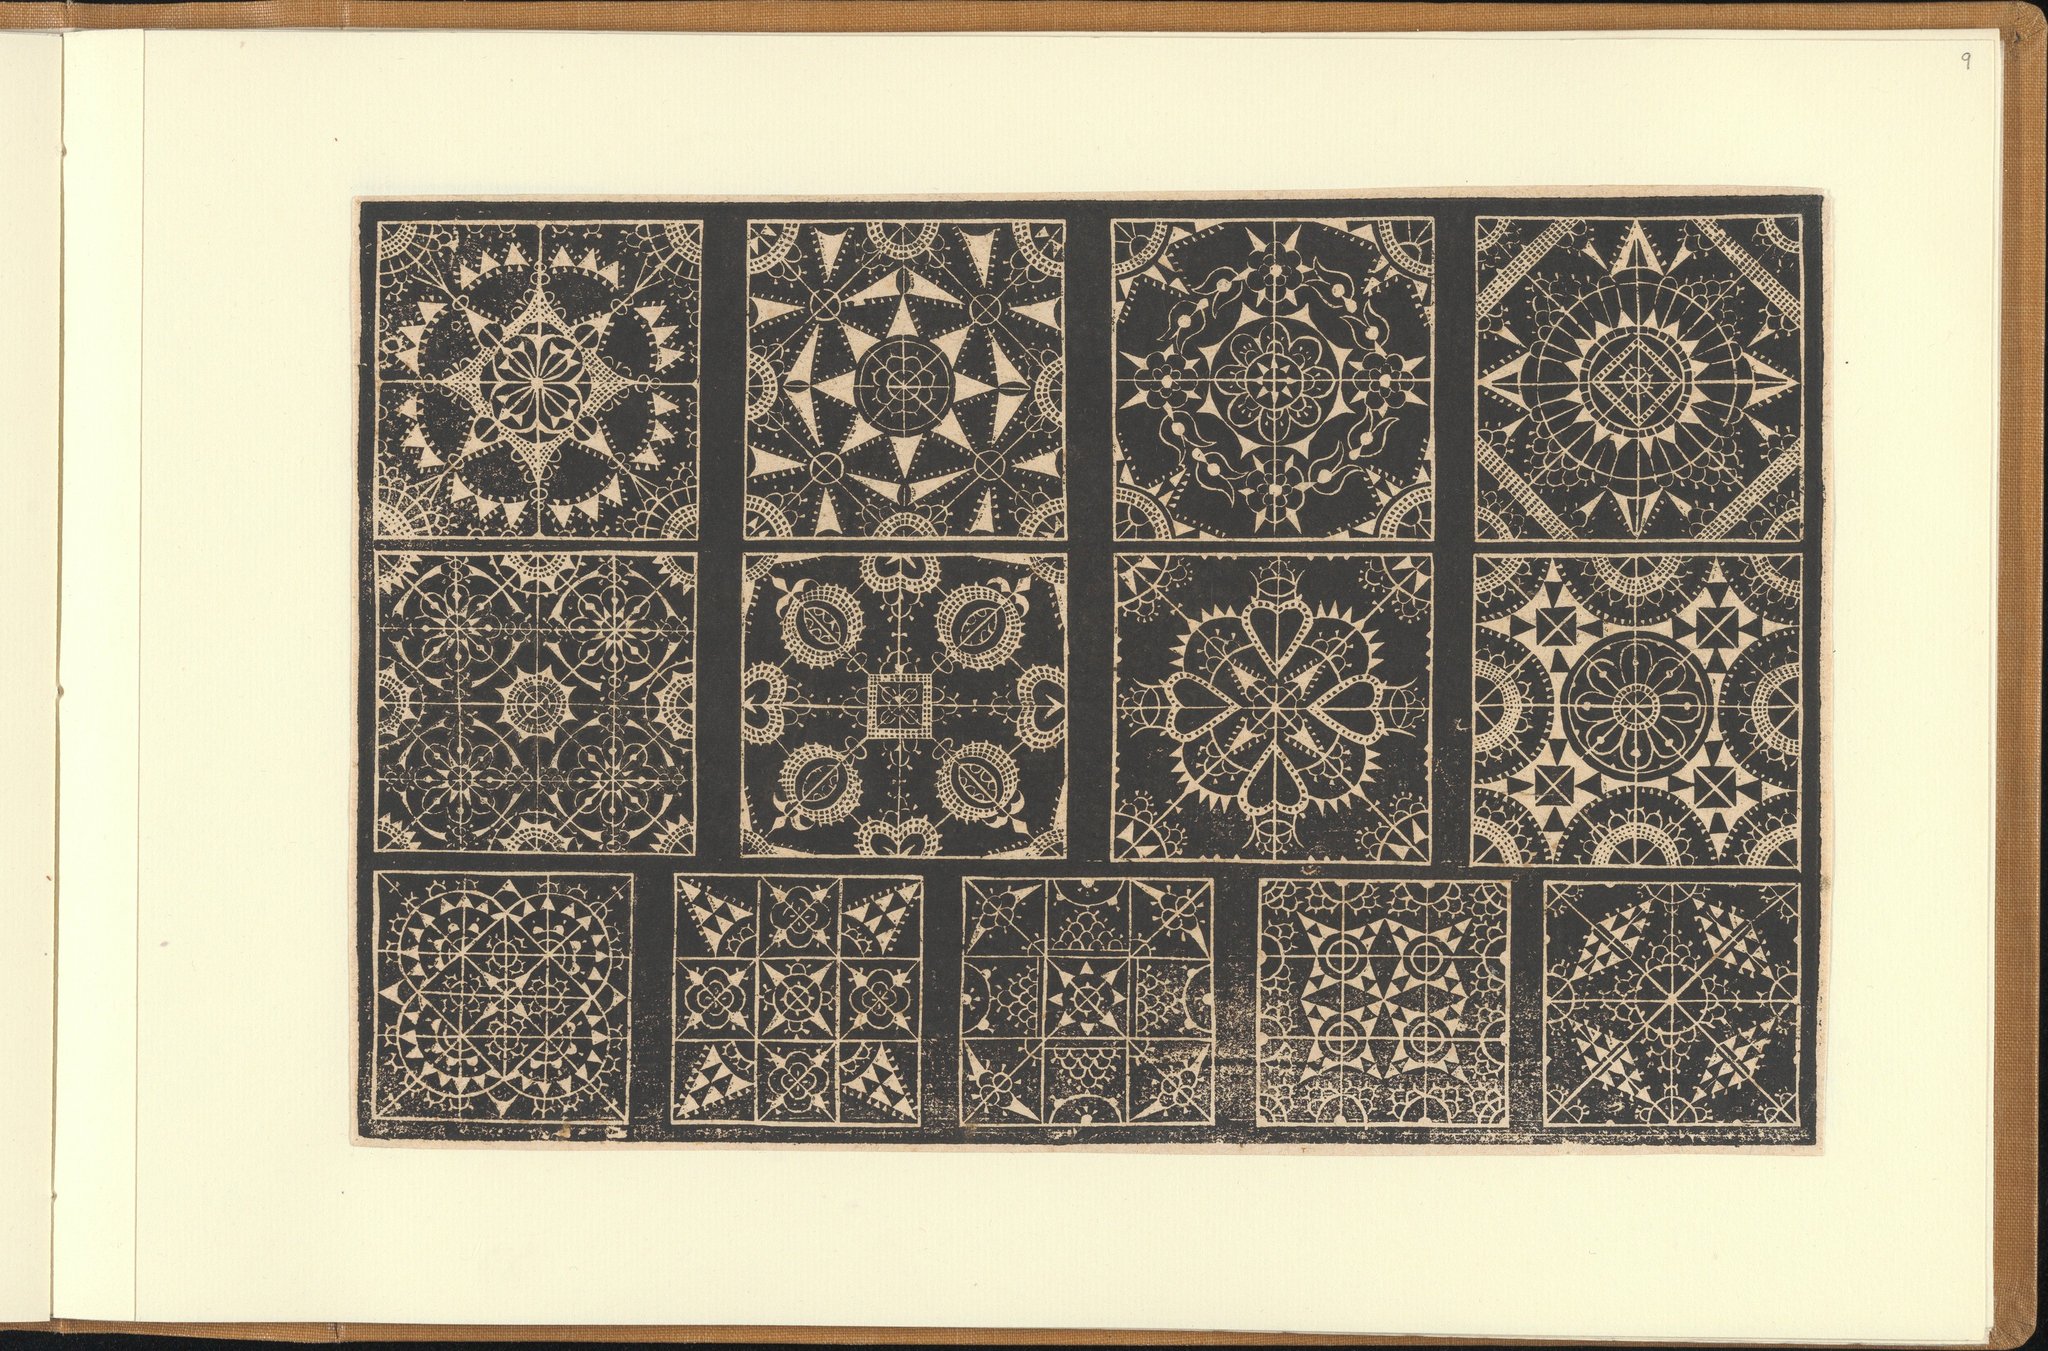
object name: album print ornament architecture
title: Schon newes Modelbuch...Page 9(r)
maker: sigismundus latomus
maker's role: designer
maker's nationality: german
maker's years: 1599-1632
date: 1617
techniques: woodcut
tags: ornament